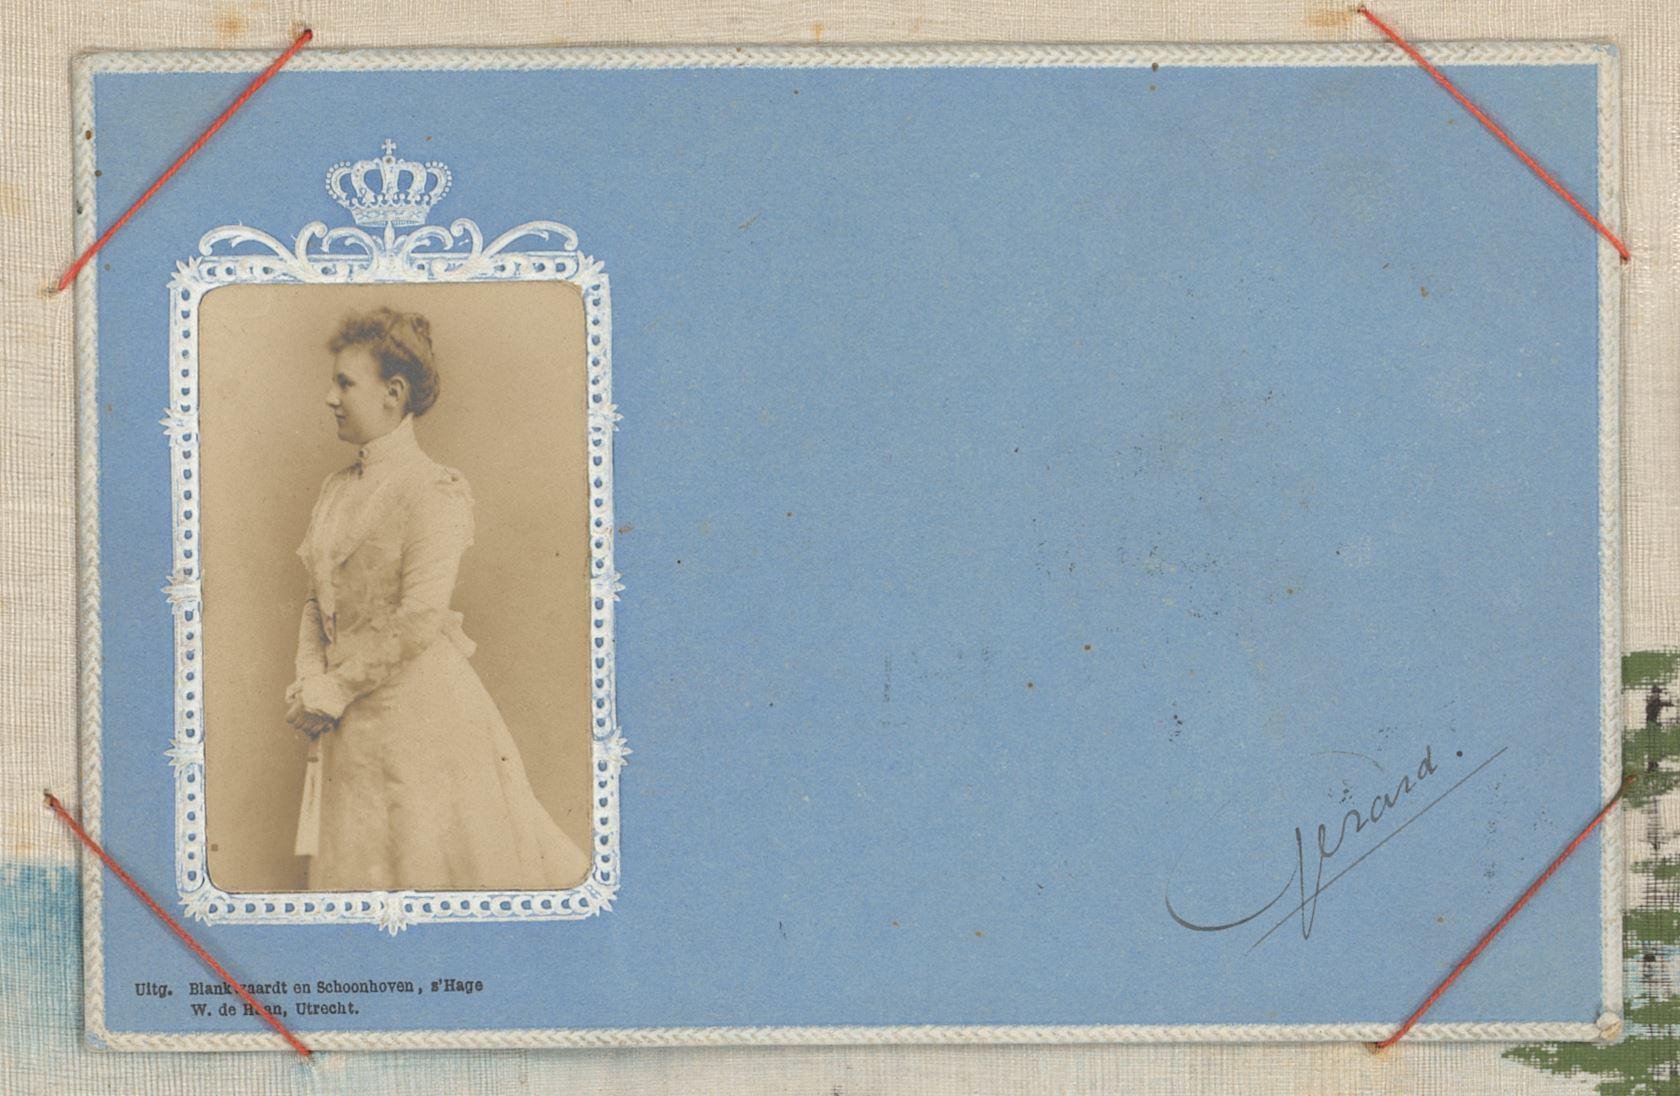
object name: photograph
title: Portret van koningin Wilhelmina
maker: Anonymous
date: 1900-1920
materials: cardboard, paint, photographic support, silk, textile, watercolor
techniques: blind stamped, brush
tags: print maker, wilhelmina of the netherlands, historical persons, queen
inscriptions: annotation: ‘[...] gerard’